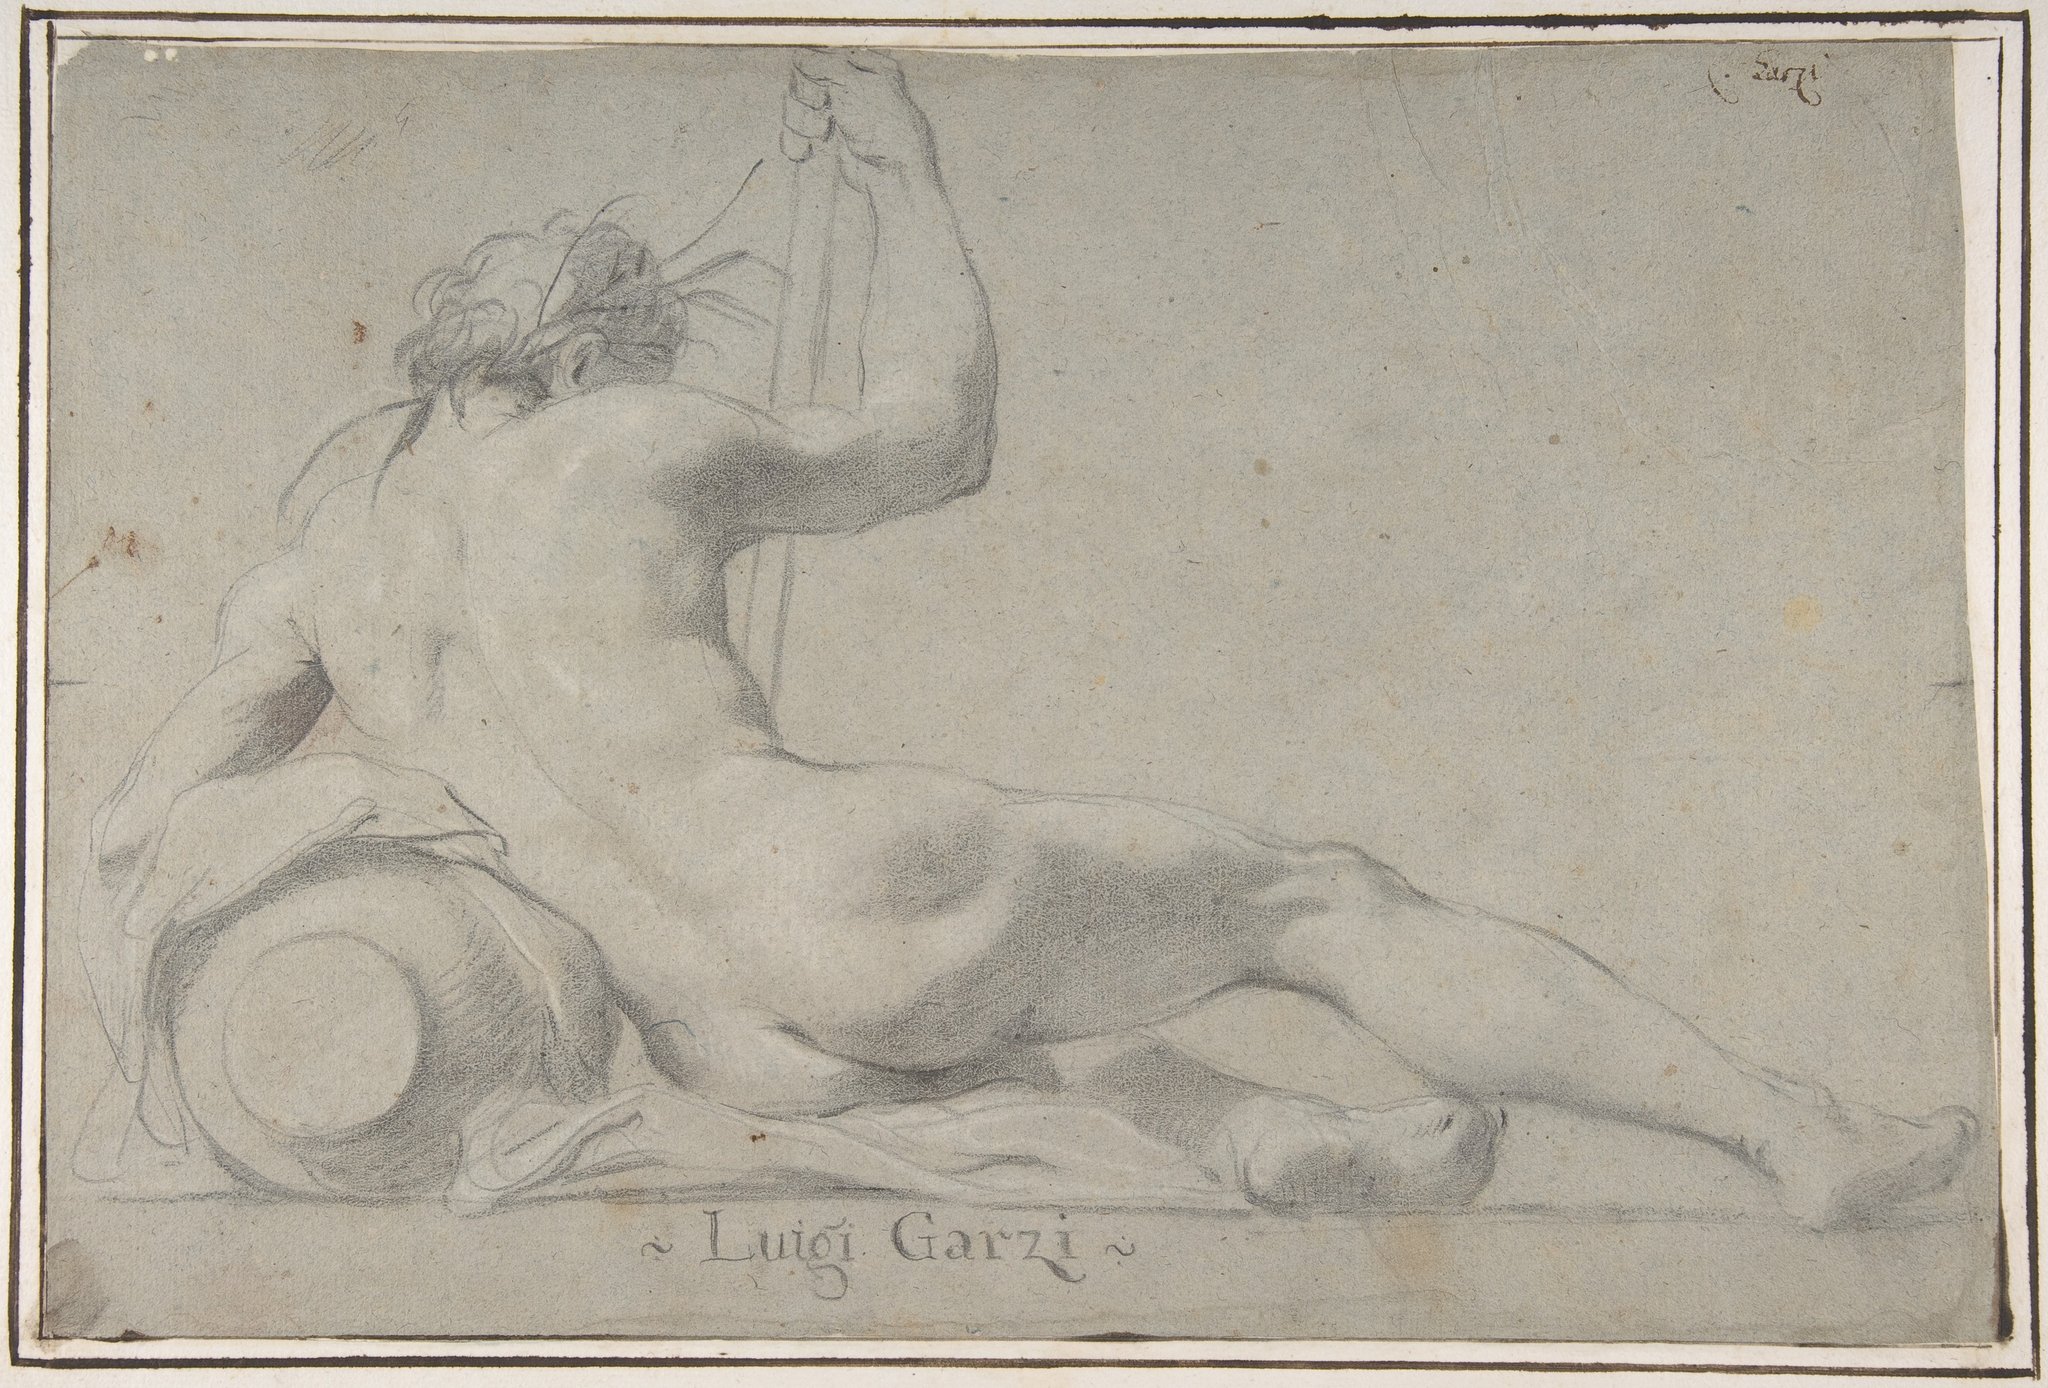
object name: drawing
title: Reclining River God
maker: luigi garzi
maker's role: artist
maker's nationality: italian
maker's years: 1638-1721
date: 1638-1721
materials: chalk, paper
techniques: highlighting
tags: male nudes